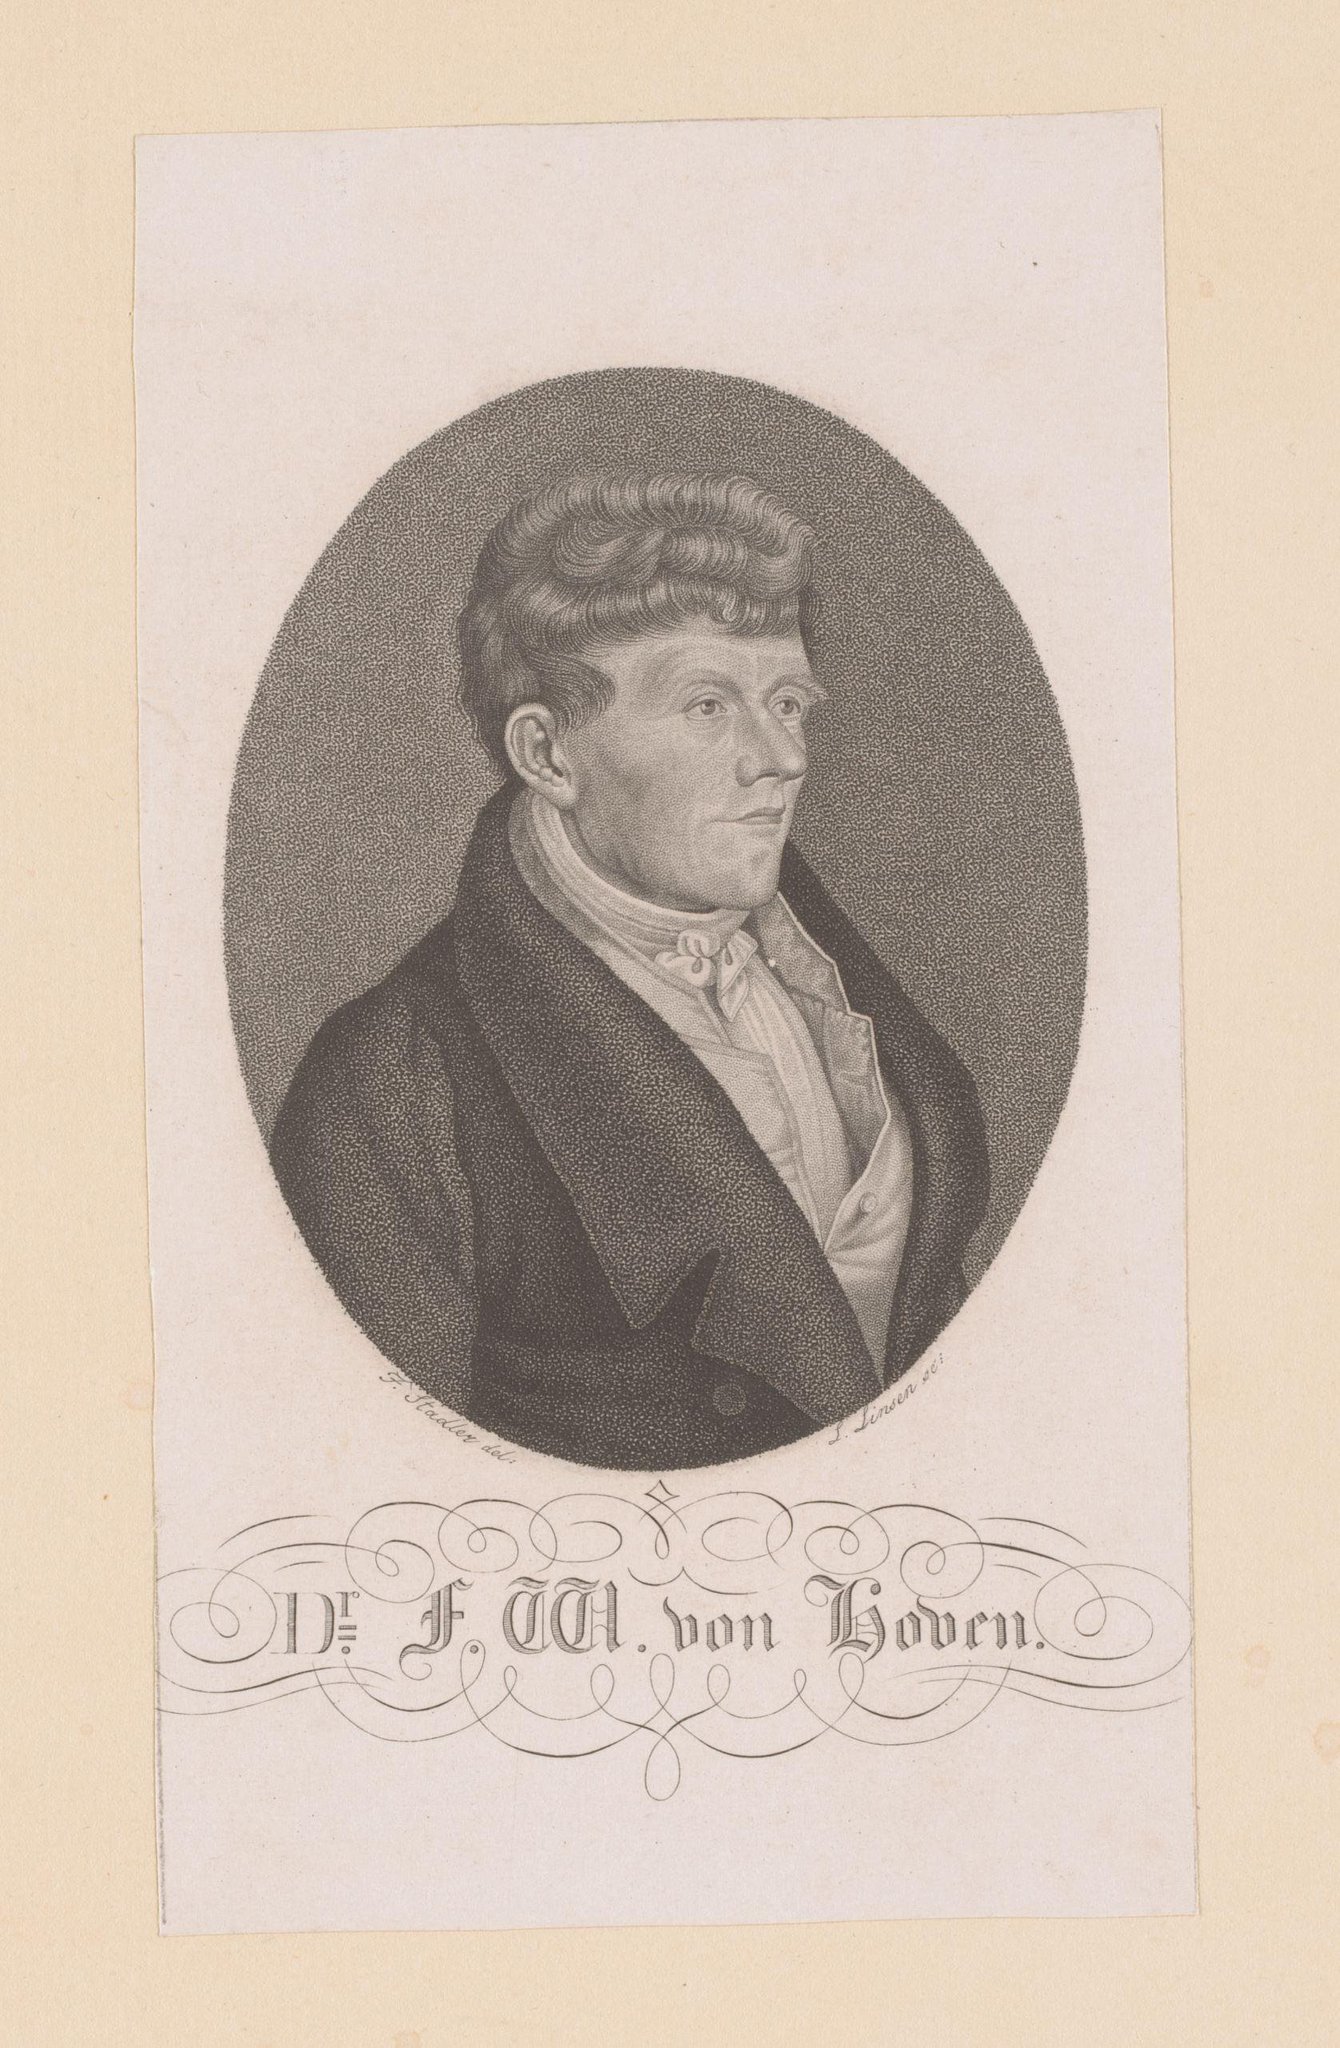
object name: print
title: Portret van Friedrich Wilhelm von Hoven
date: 1839-1856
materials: paper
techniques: stippling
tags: further education (+ portrait of teacher, professor), historical persons, physician, doctor (+ portrait of scholar, scientist)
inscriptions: collector's mark: Lugt 2228